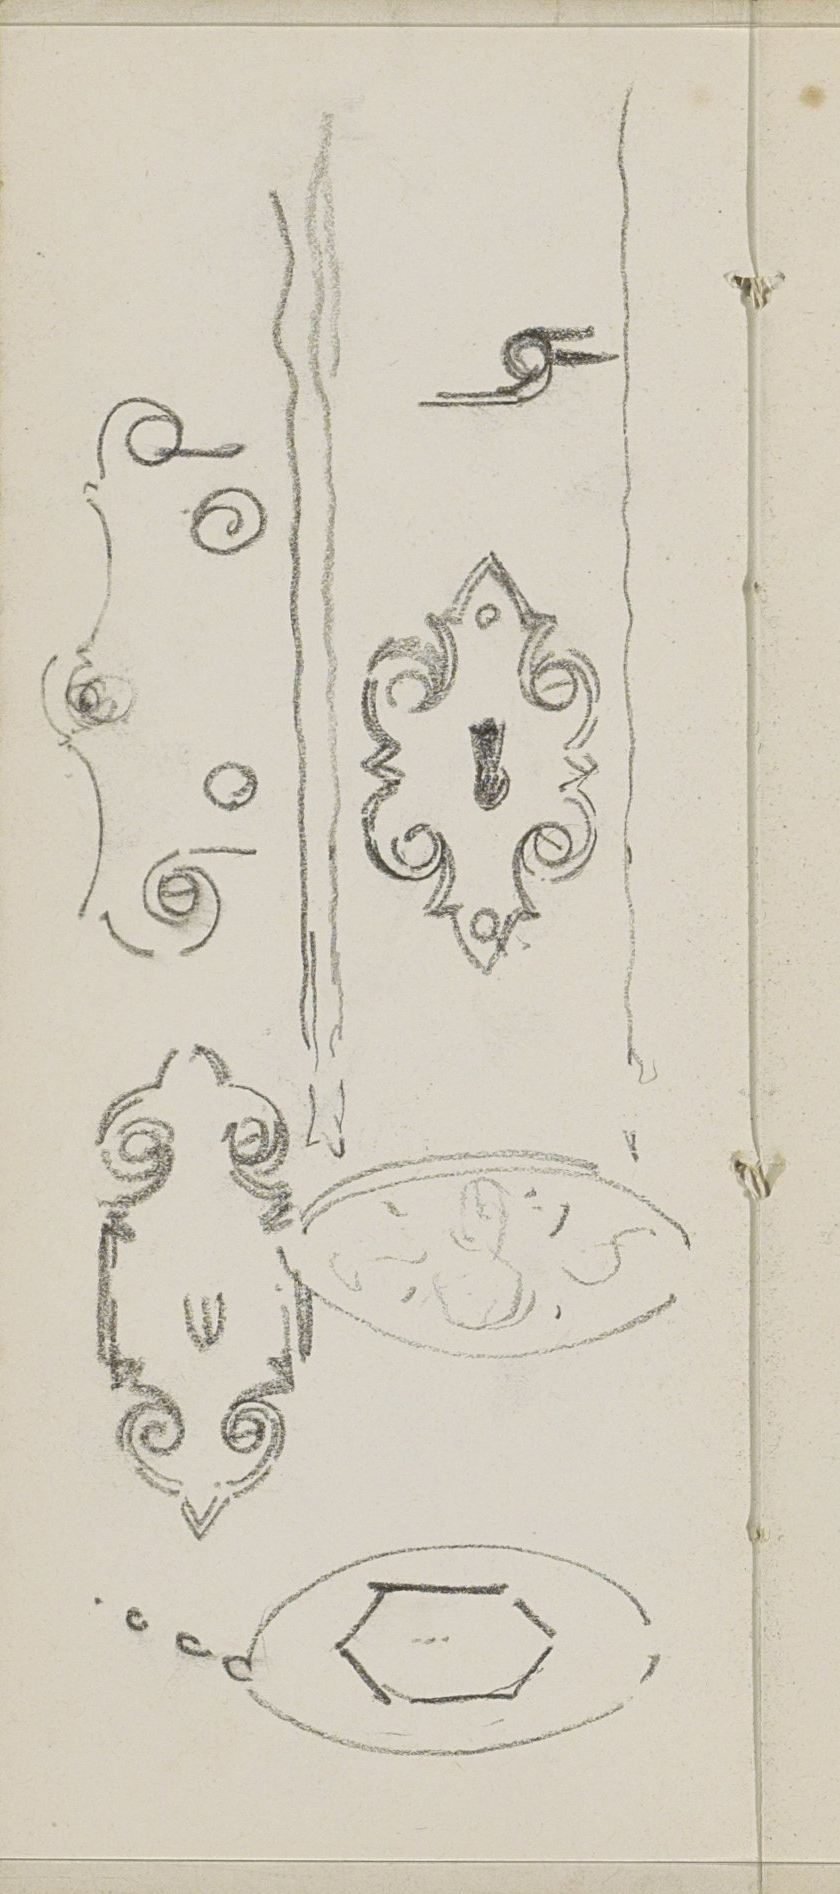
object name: sketchbook leaf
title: Sleutelgaten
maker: gerrit willem dijsselhof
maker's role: designer, draughtsman, print maker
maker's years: 1866-1924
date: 1876-1924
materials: chalk, paper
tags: lock ~ door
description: Blad 31 verso uit een schetsboek met 40 bladen.